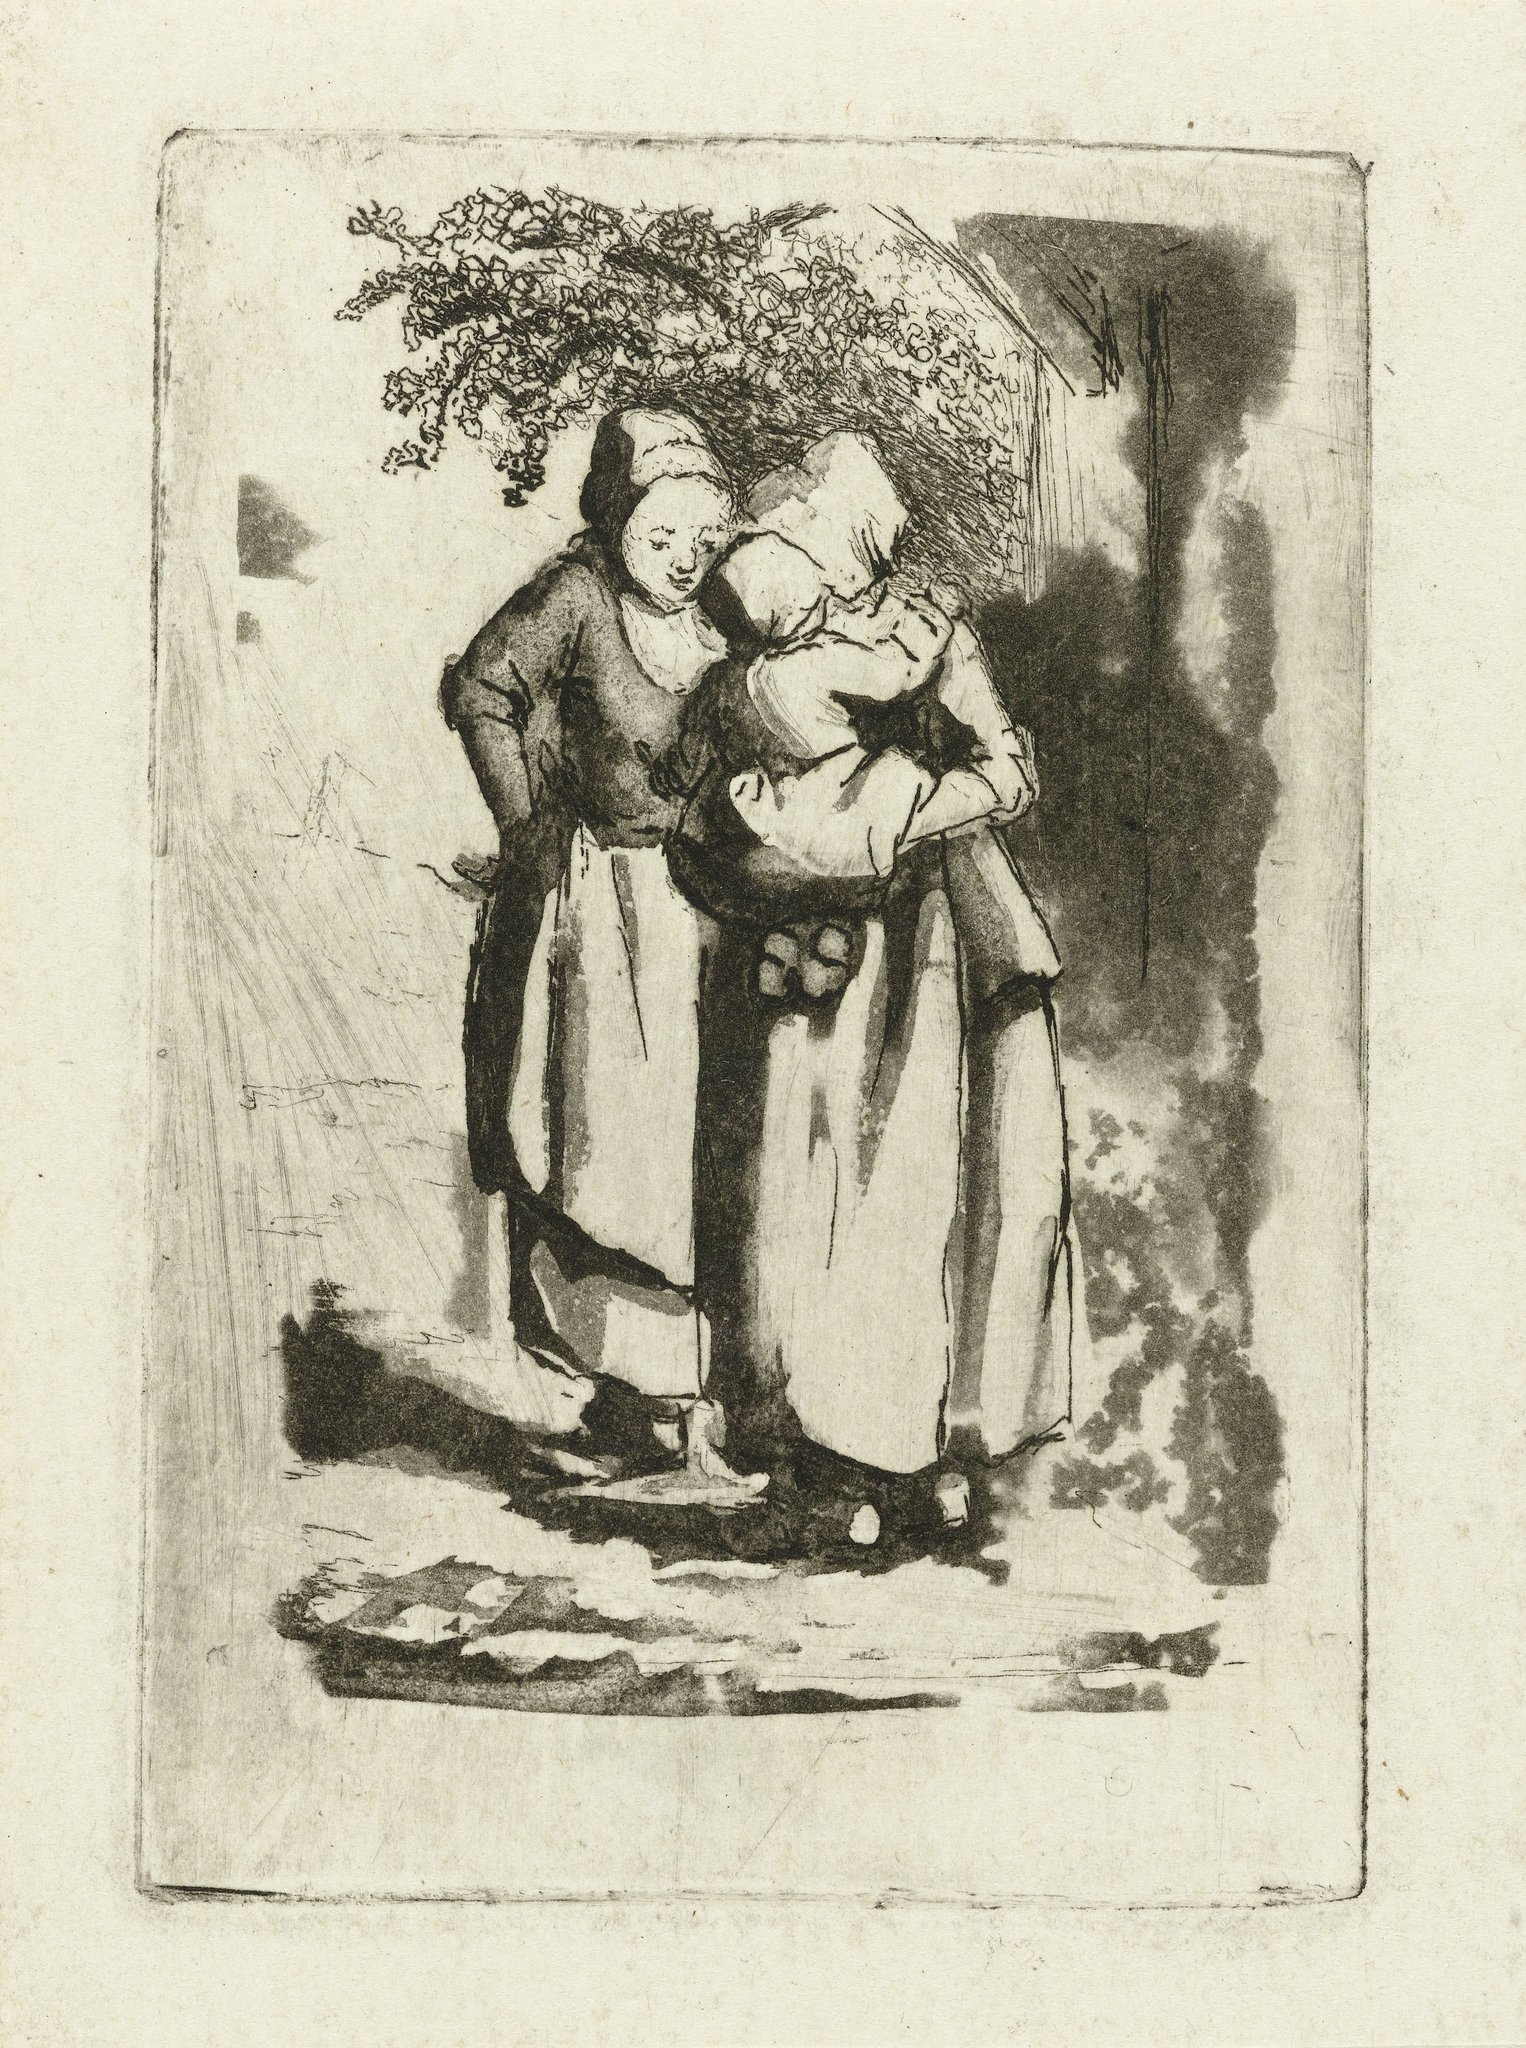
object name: print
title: Twee staande boerinnen, eentje met een kind op haar arm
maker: marie lambertine coclers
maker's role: conservator, draughtsman, print maker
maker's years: 1761-1815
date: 1776-1815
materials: paper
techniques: aquatint, drypoint, etching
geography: amsterdam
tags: mother and baby or young child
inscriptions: collector's mark: Lugt 2228